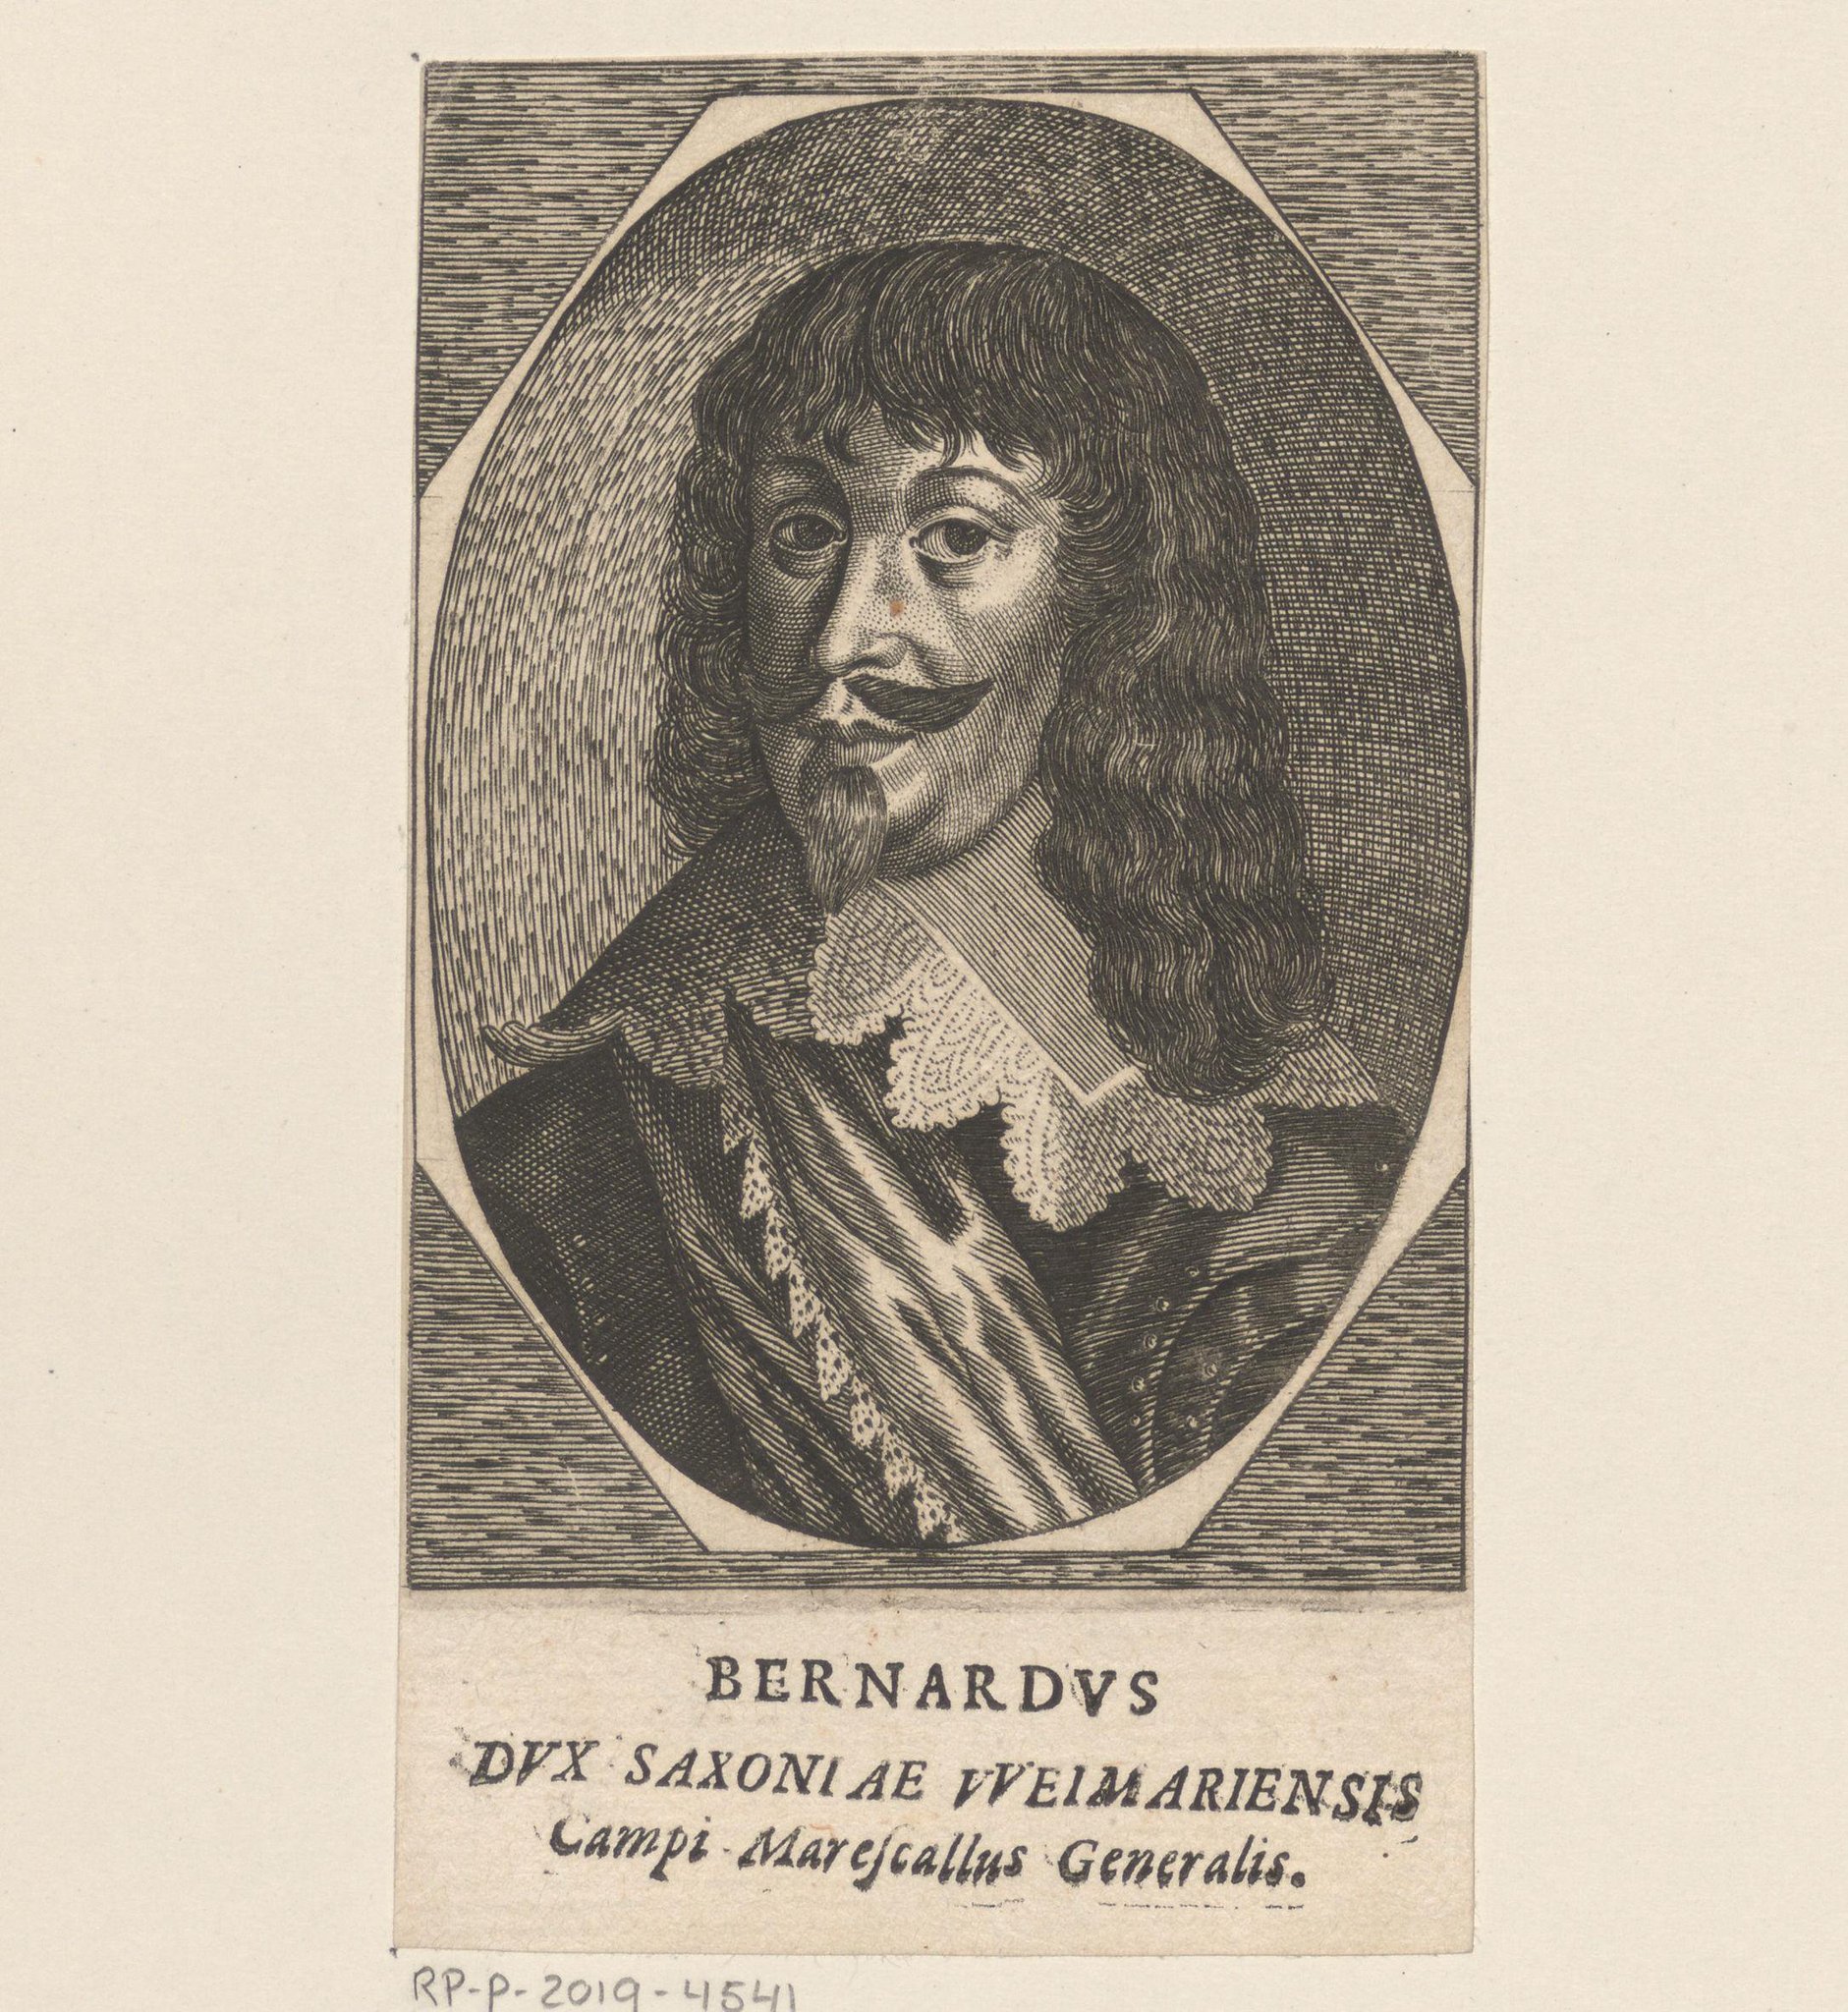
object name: print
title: Portret van Bernhard, hertog van Saksen-Weimar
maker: Anonymous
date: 1650-1699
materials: paper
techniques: engraving, etching, letterpress printing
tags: historical persons